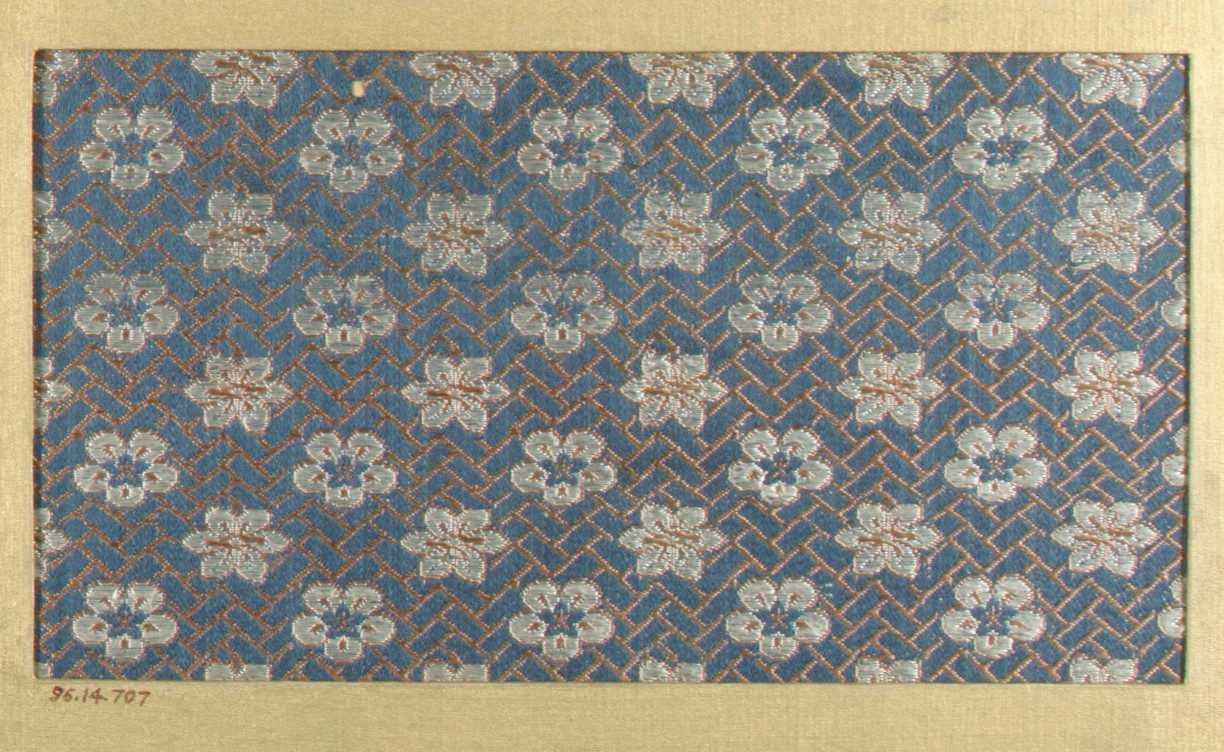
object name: piece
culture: japanese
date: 1701-1900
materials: silk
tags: flowers